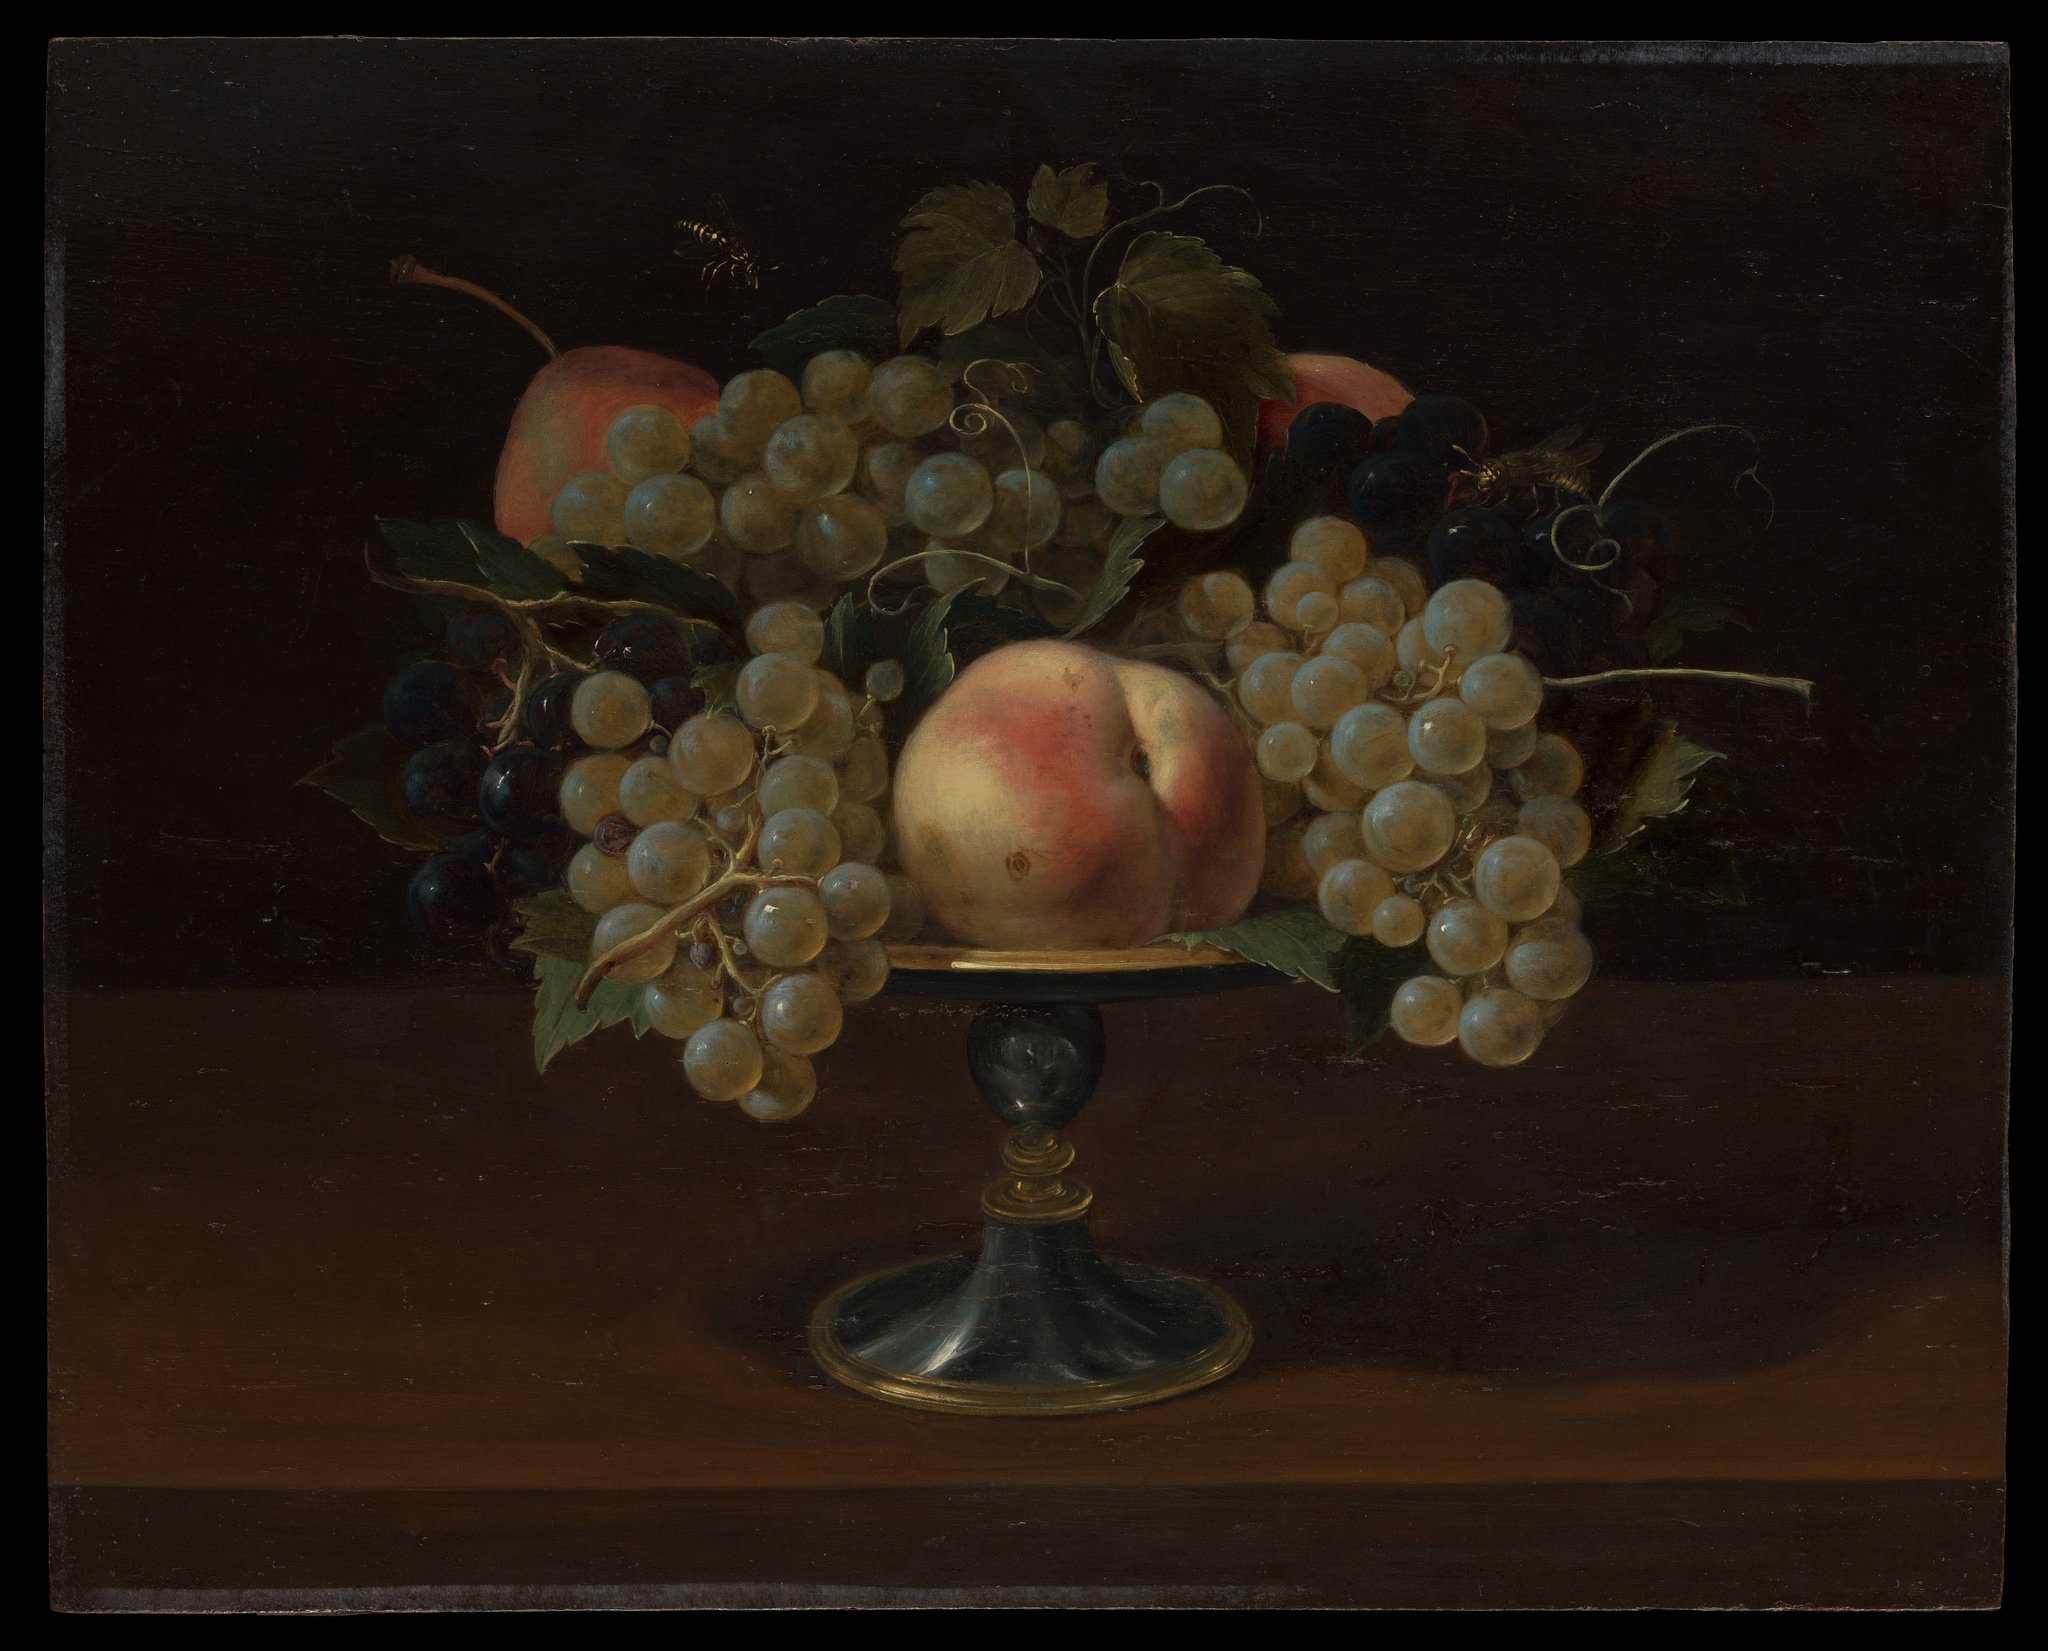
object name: painting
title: Still Life of Grapes and Peaches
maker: panfilo nuvolone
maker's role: artist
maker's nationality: italian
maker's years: 1578-1651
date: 1617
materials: oil, wood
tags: fruit,grapes,peaches,still life